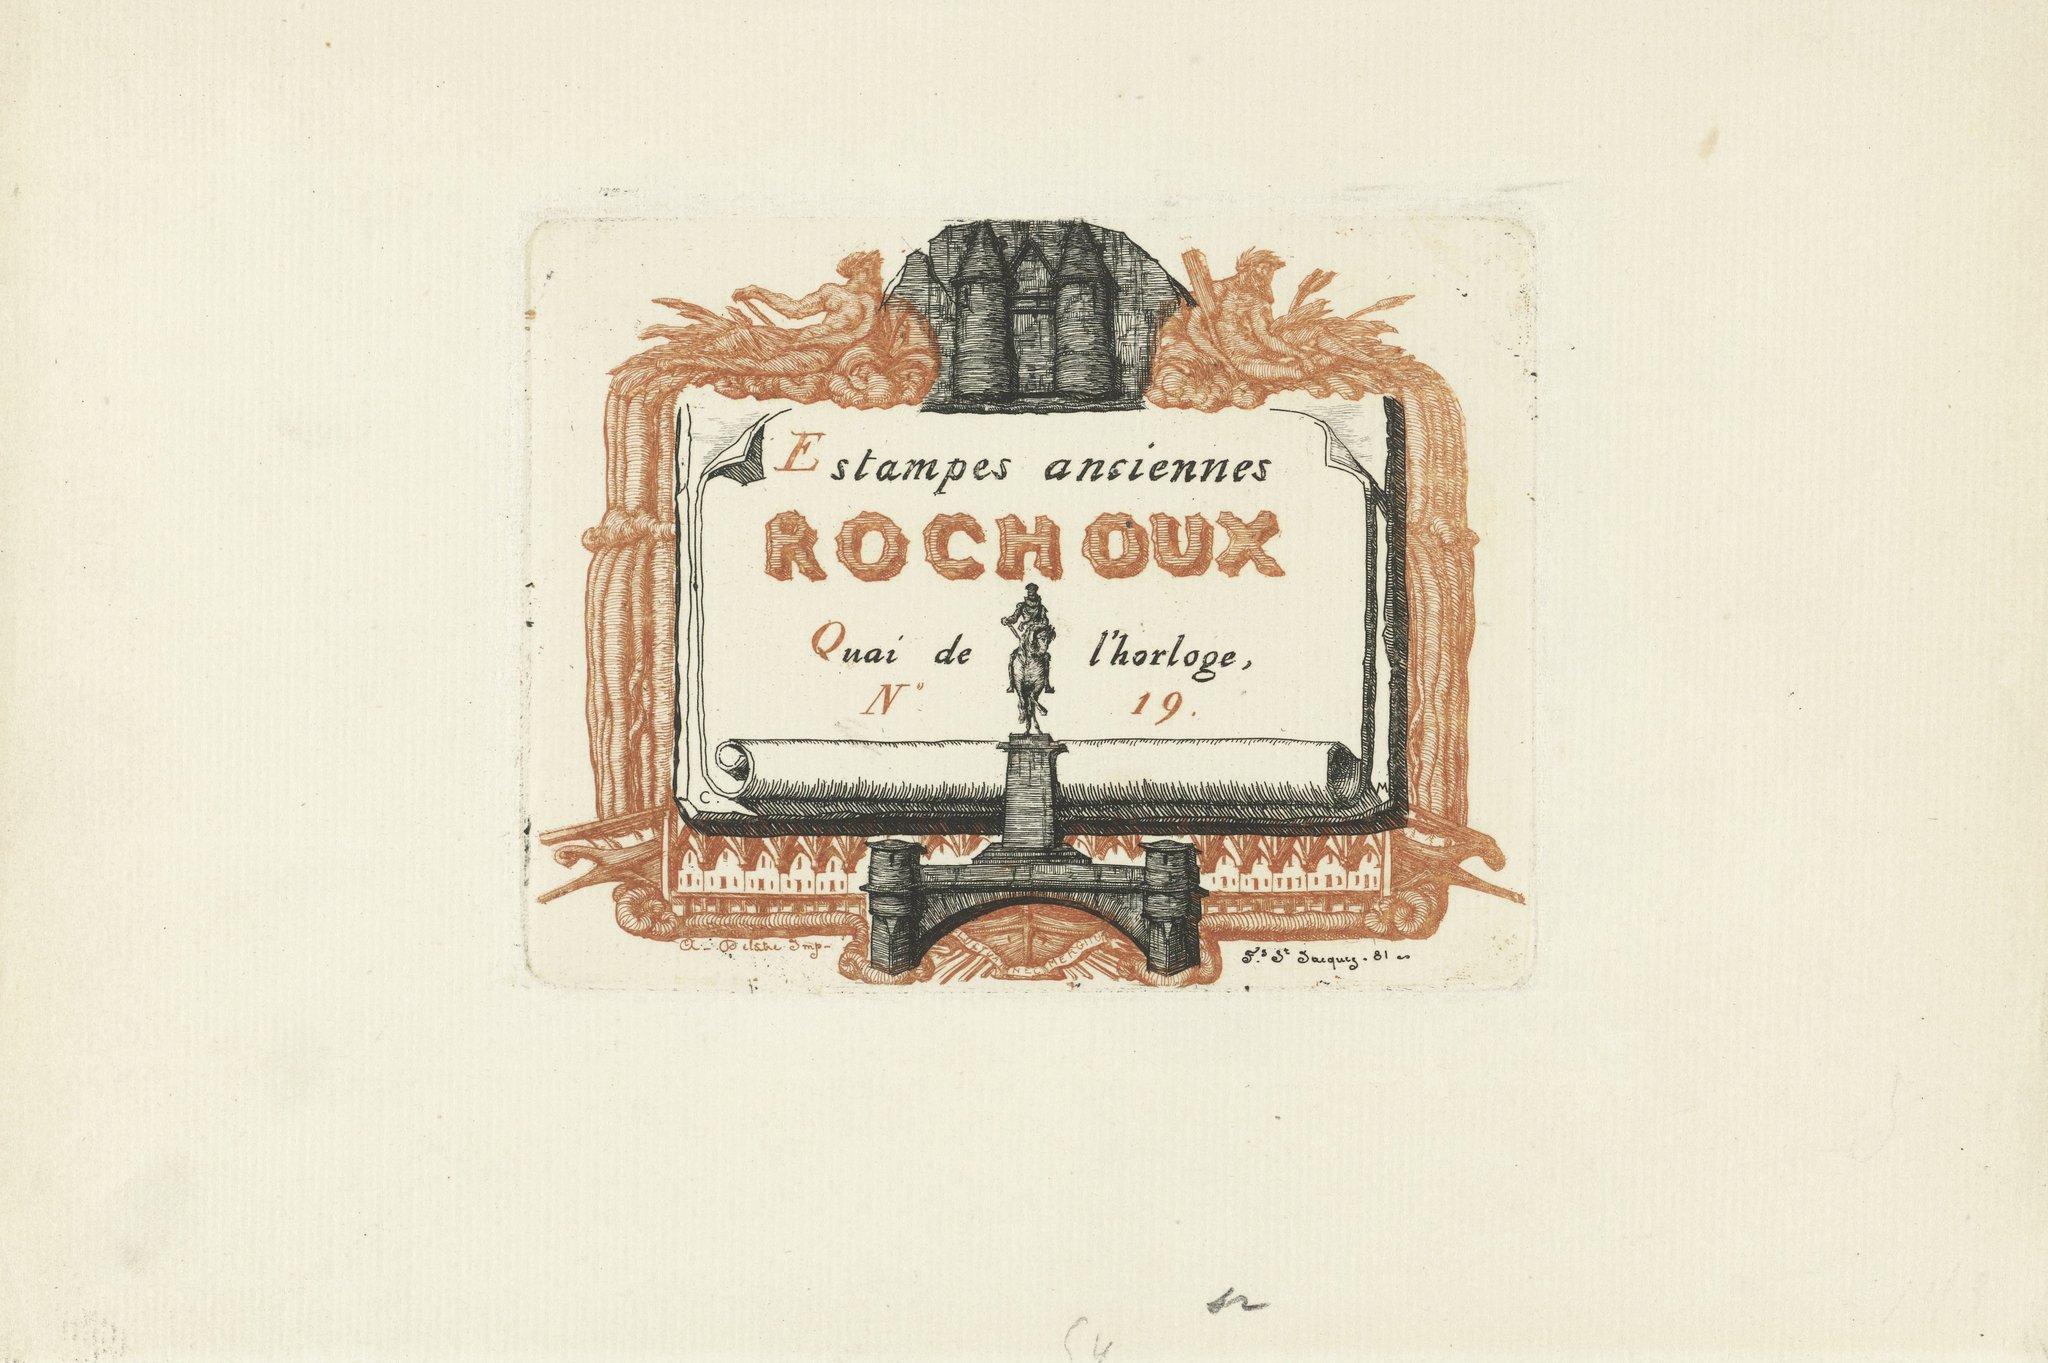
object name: print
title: Adresse de Rochoux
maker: charles meryon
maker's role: print maker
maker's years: 1821-1868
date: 1855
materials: paper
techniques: color etching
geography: france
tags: gate, entrance, visiting-card, calling-card, equestrian statue, bridge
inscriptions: collector's mark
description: Adreskaart van de prenthandel Rochoux met de tekst Estampes anciennes ROCHOUX, quai de l'Horloge no 19 afgebeeld op een blad papier. Boven het adres zijn een riviergod en riviergodin weergegeven als personificaties van de rivieren de Seine en de Marne. Zij flankeren de poort van het Paleis van Justitie. Onder staat het ruiterstandbeeld van Henry IV op een sokkel boven een boog van de Pont-Neuf.